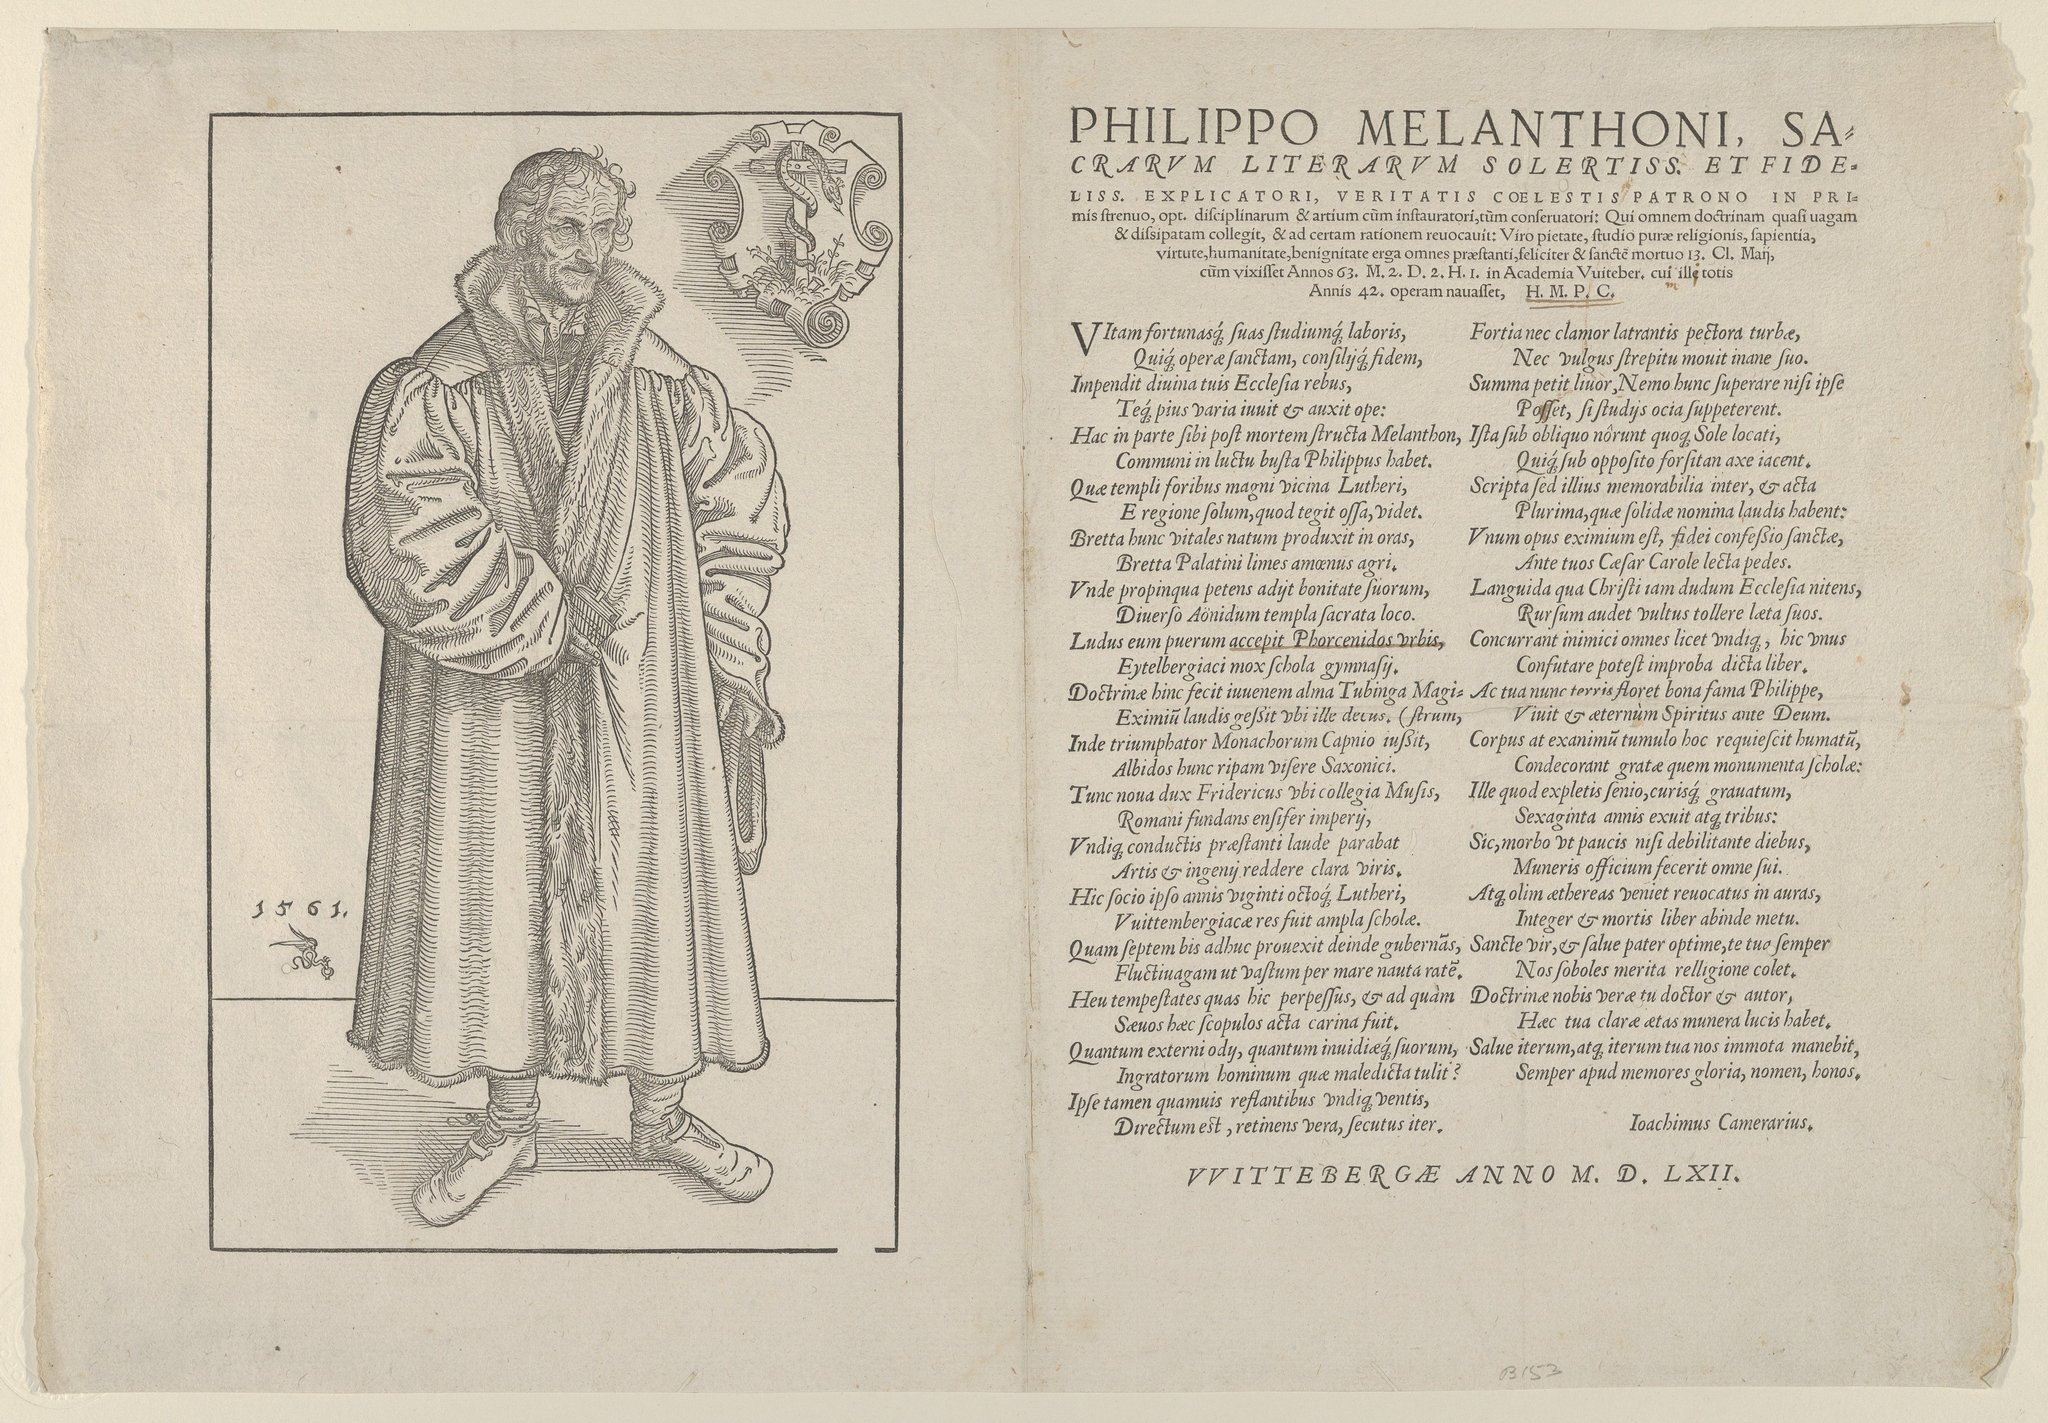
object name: print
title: Philip Melanchthon, Full-Length Towards the Right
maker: lucas cranach the younger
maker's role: artist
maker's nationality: german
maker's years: 1515-1586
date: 1561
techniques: woodcut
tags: men